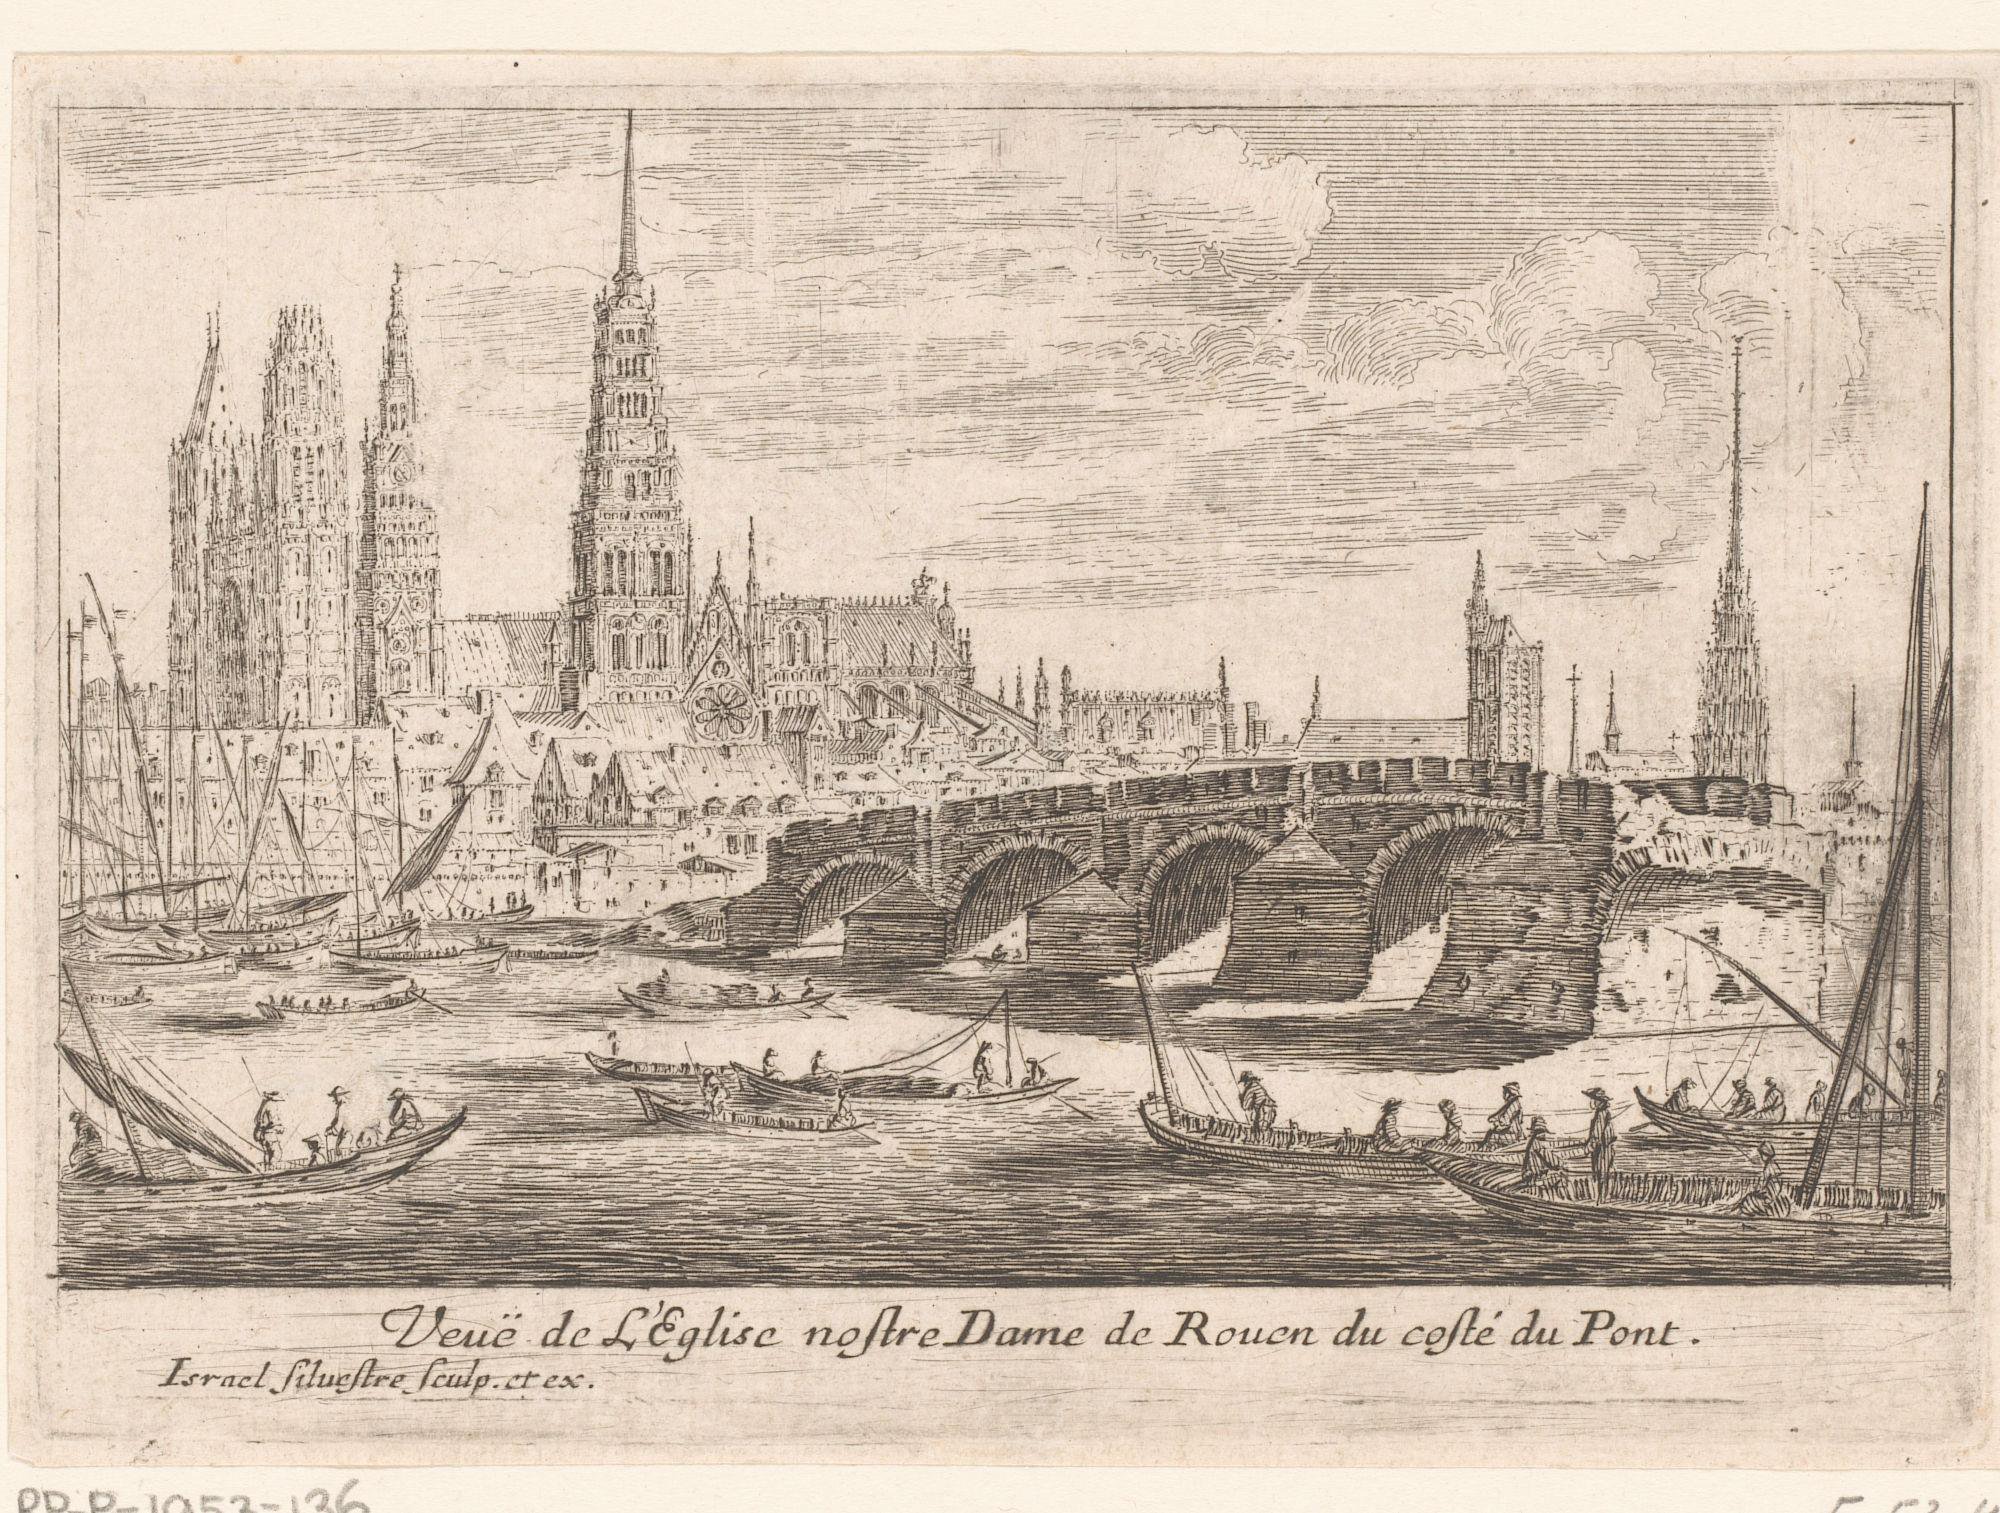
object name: print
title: Gezicht op de Notre-Dame in Rouen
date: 1631-1691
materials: paper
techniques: etching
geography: france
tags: landscape with bridge, viaduct or aqueduct, church (exterior), boat propelled by man or animal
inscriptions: collector's mark: Lugt 240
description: Prent maakt deel uit van een genummerde serie van negen prenten, maar de nummers zijn afgesneden. Dit is vermoedelijk nummer 4.